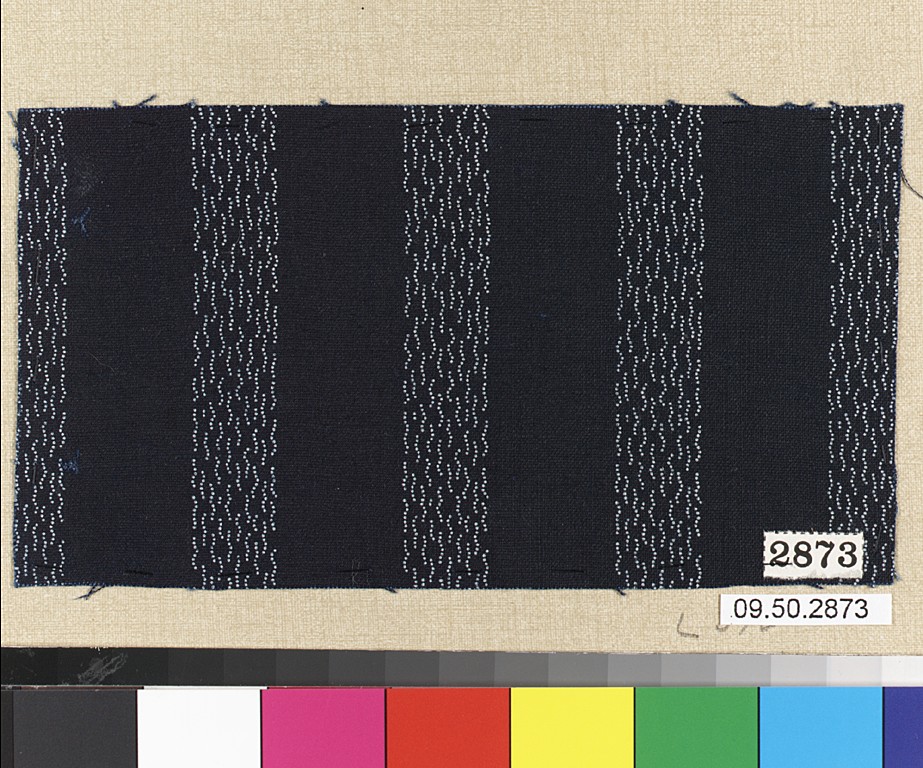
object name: piece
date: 1801-1900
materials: cotton